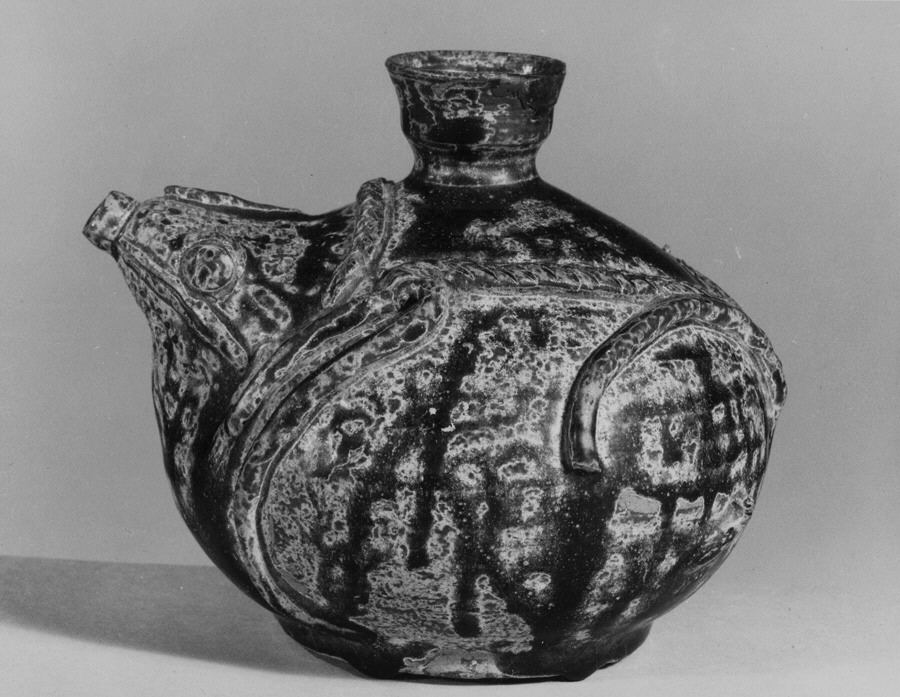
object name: vessel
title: Vessel in the Form of a Frog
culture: thai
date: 1301-1500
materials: earthenware